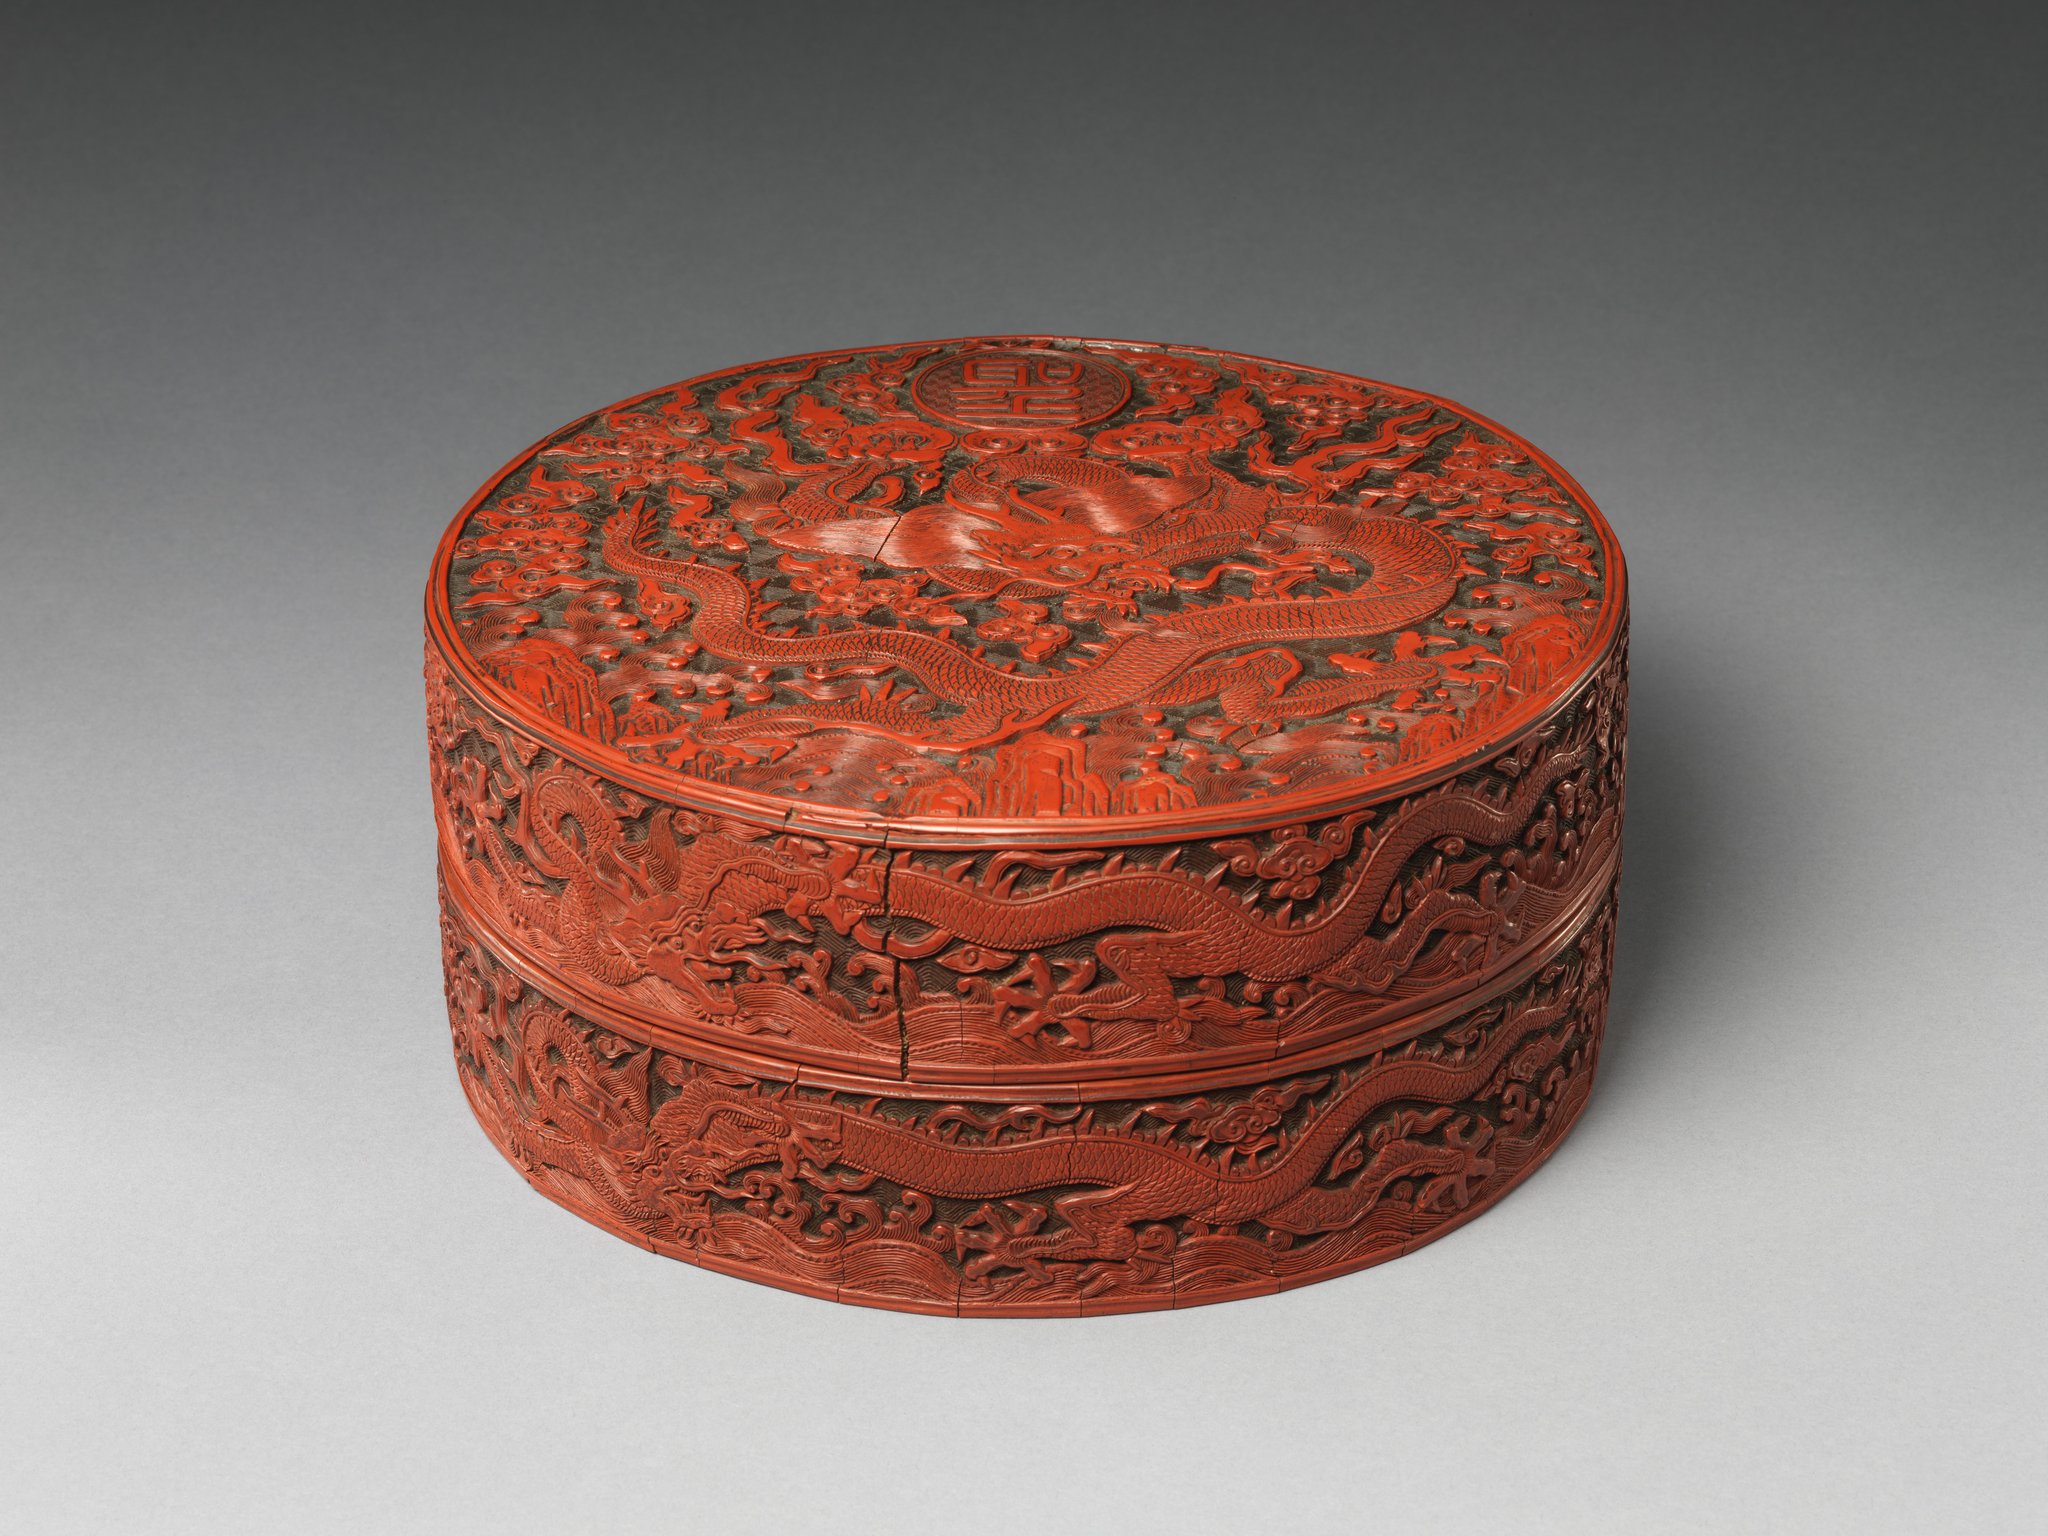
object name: box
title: Box with dragon design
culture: chinese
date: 1522-1566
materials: lacquer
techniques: carving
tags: dragons